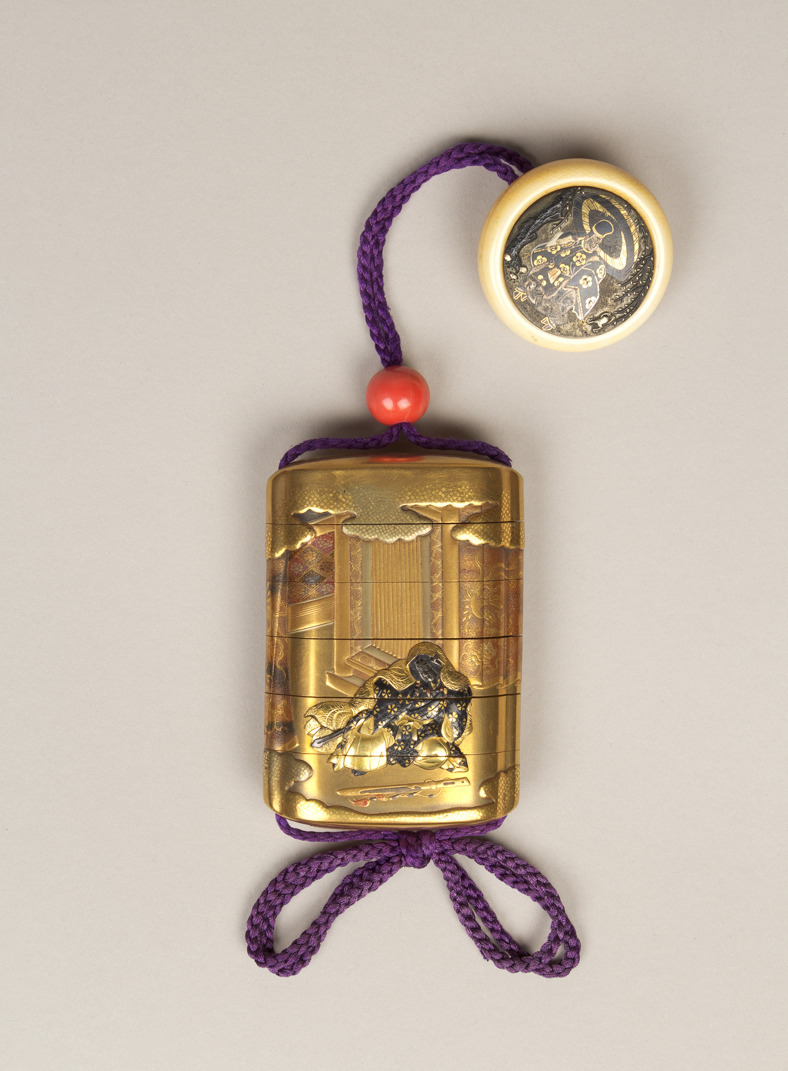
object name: inrō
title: Inrō with Prince Yamato Takeru Disguised as a Woman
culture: japanese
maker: bairin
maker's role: artist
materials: coral, gold, gold foil, gold leaf, ivory, metal, silver, wood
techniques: cutting, hiramakie, lacquer, maki-e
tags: swords,men,women